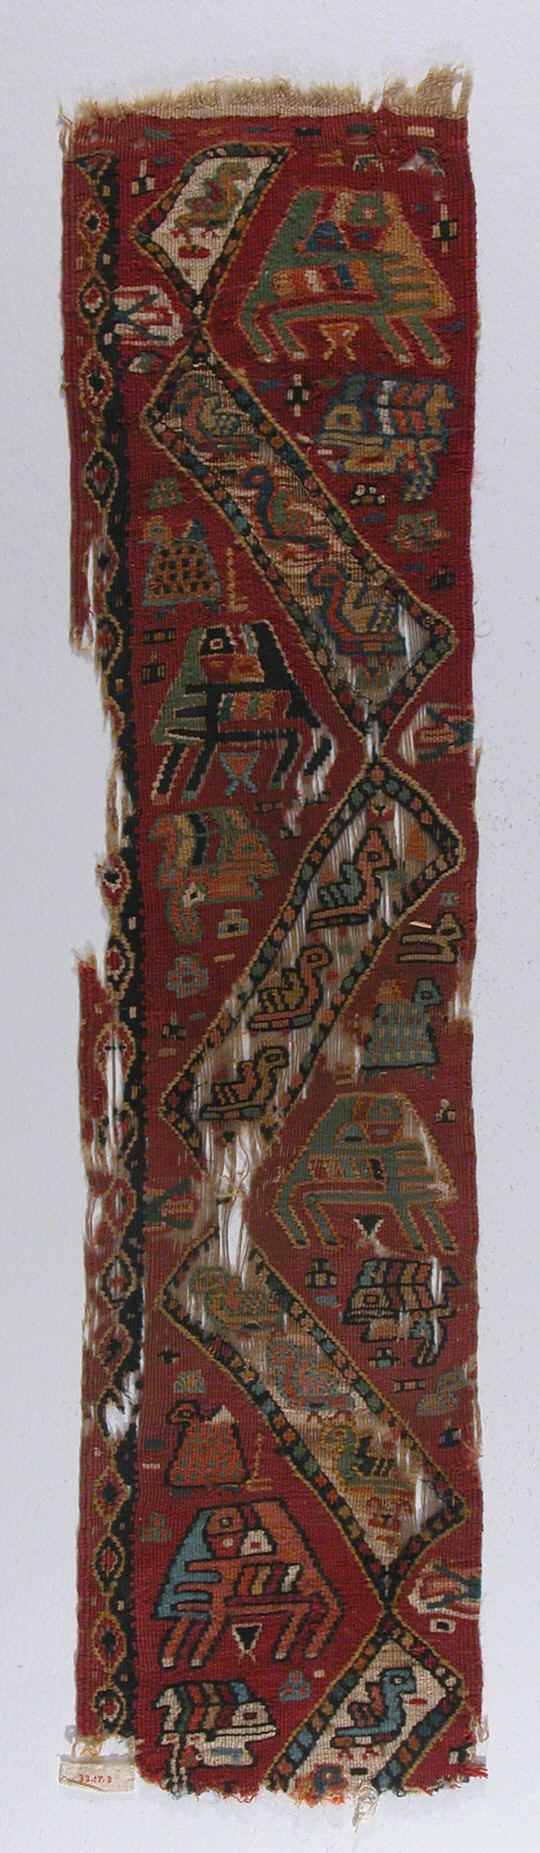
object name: fragment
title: Textile Fragment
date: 701-800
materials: linen, wool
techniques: weave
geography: egypt